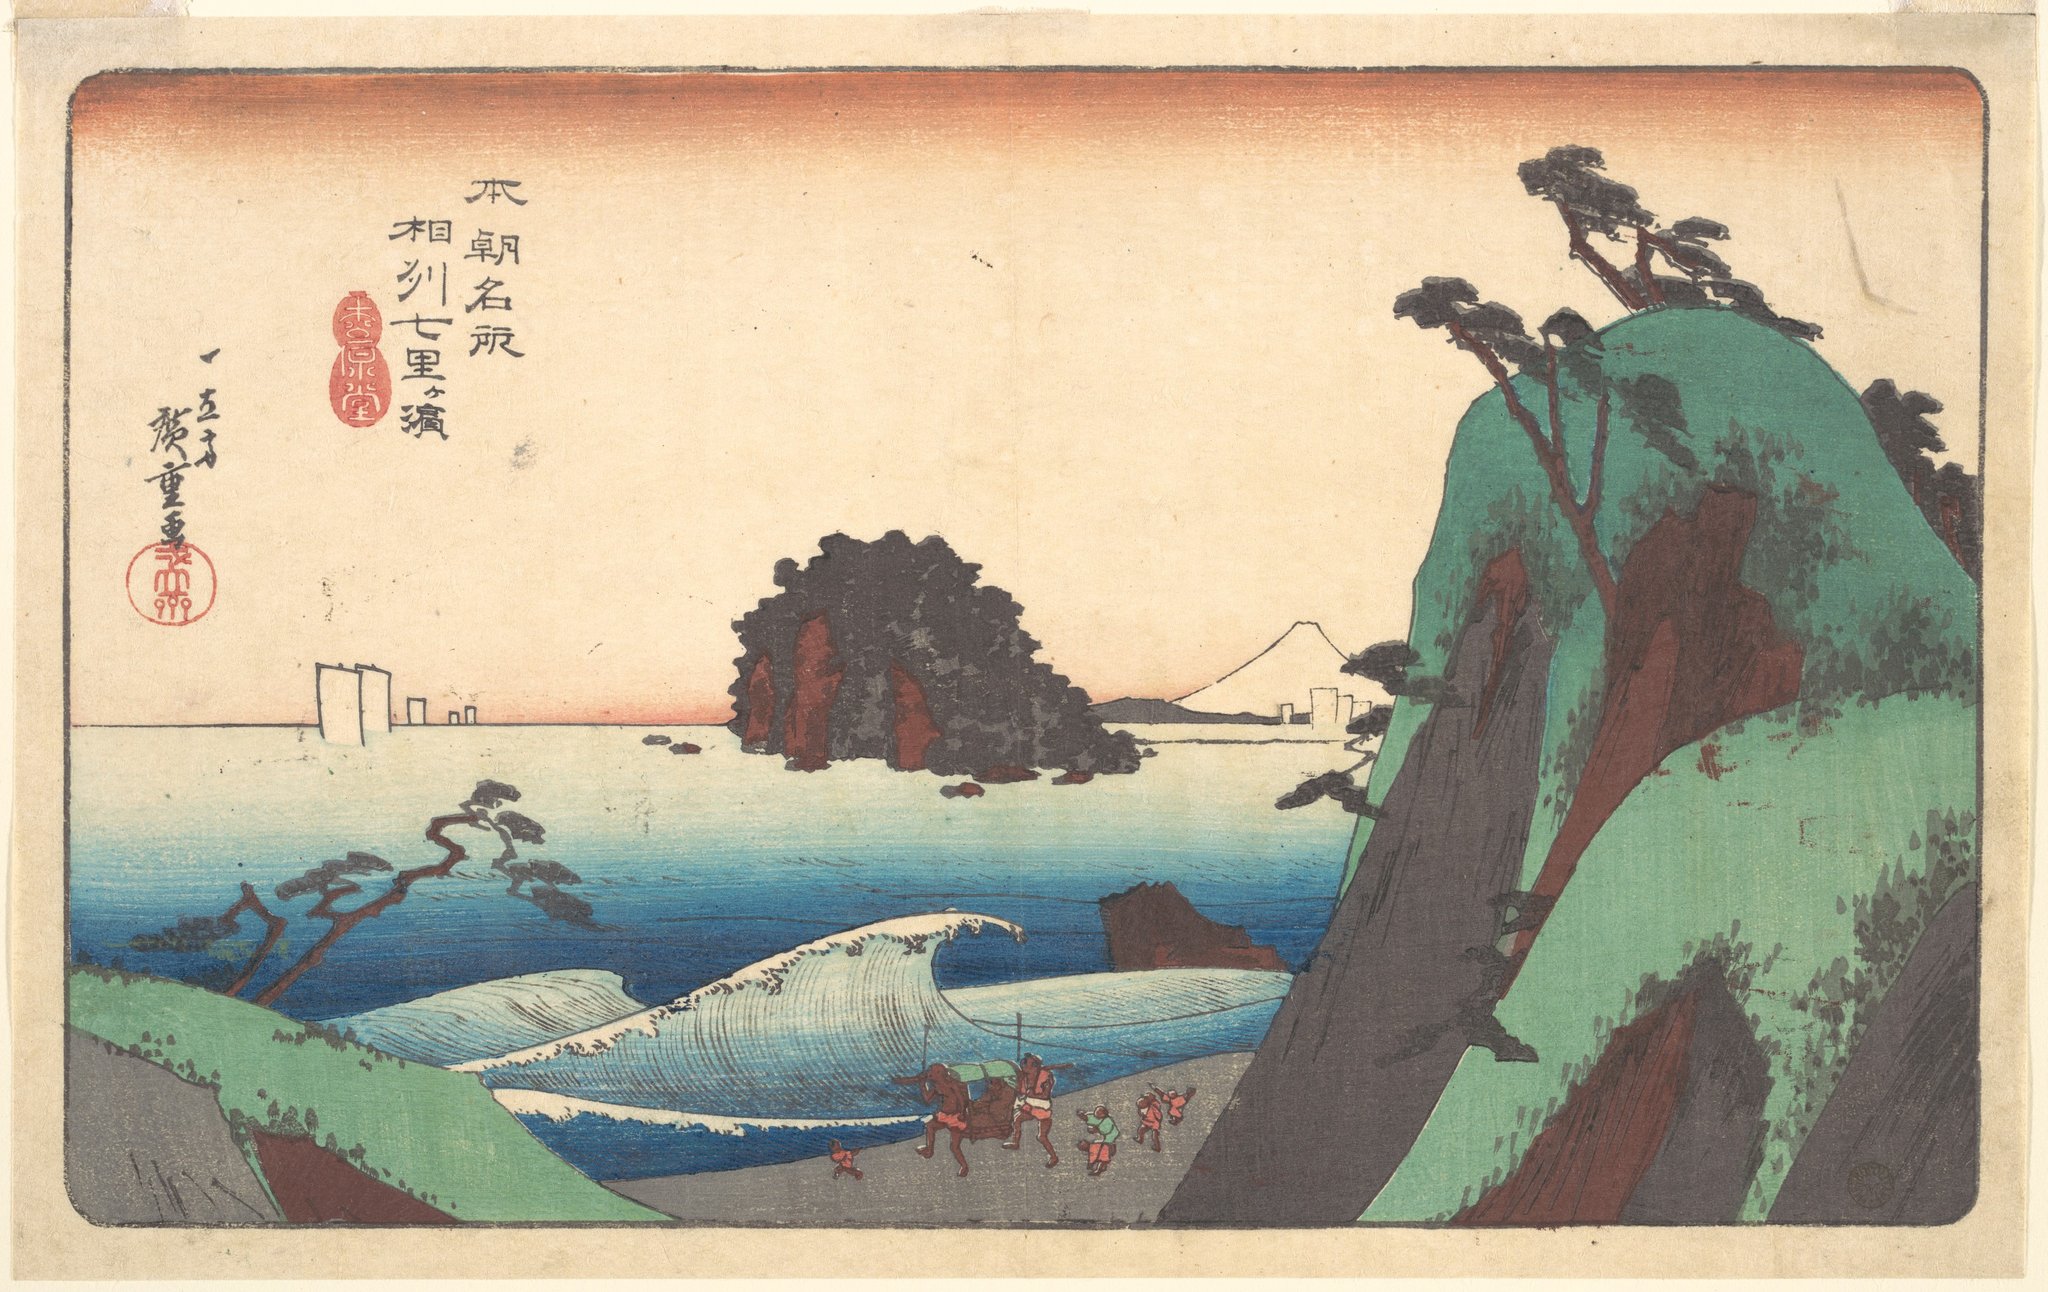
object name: print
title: Soshu, Shichi-ri ga Hama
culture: japanese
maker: utagawa hiroshige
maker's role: artist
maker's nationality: japanese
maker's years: 1797-1858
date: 1830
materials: ink, paper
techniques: woodblock print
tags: landscapes,waves